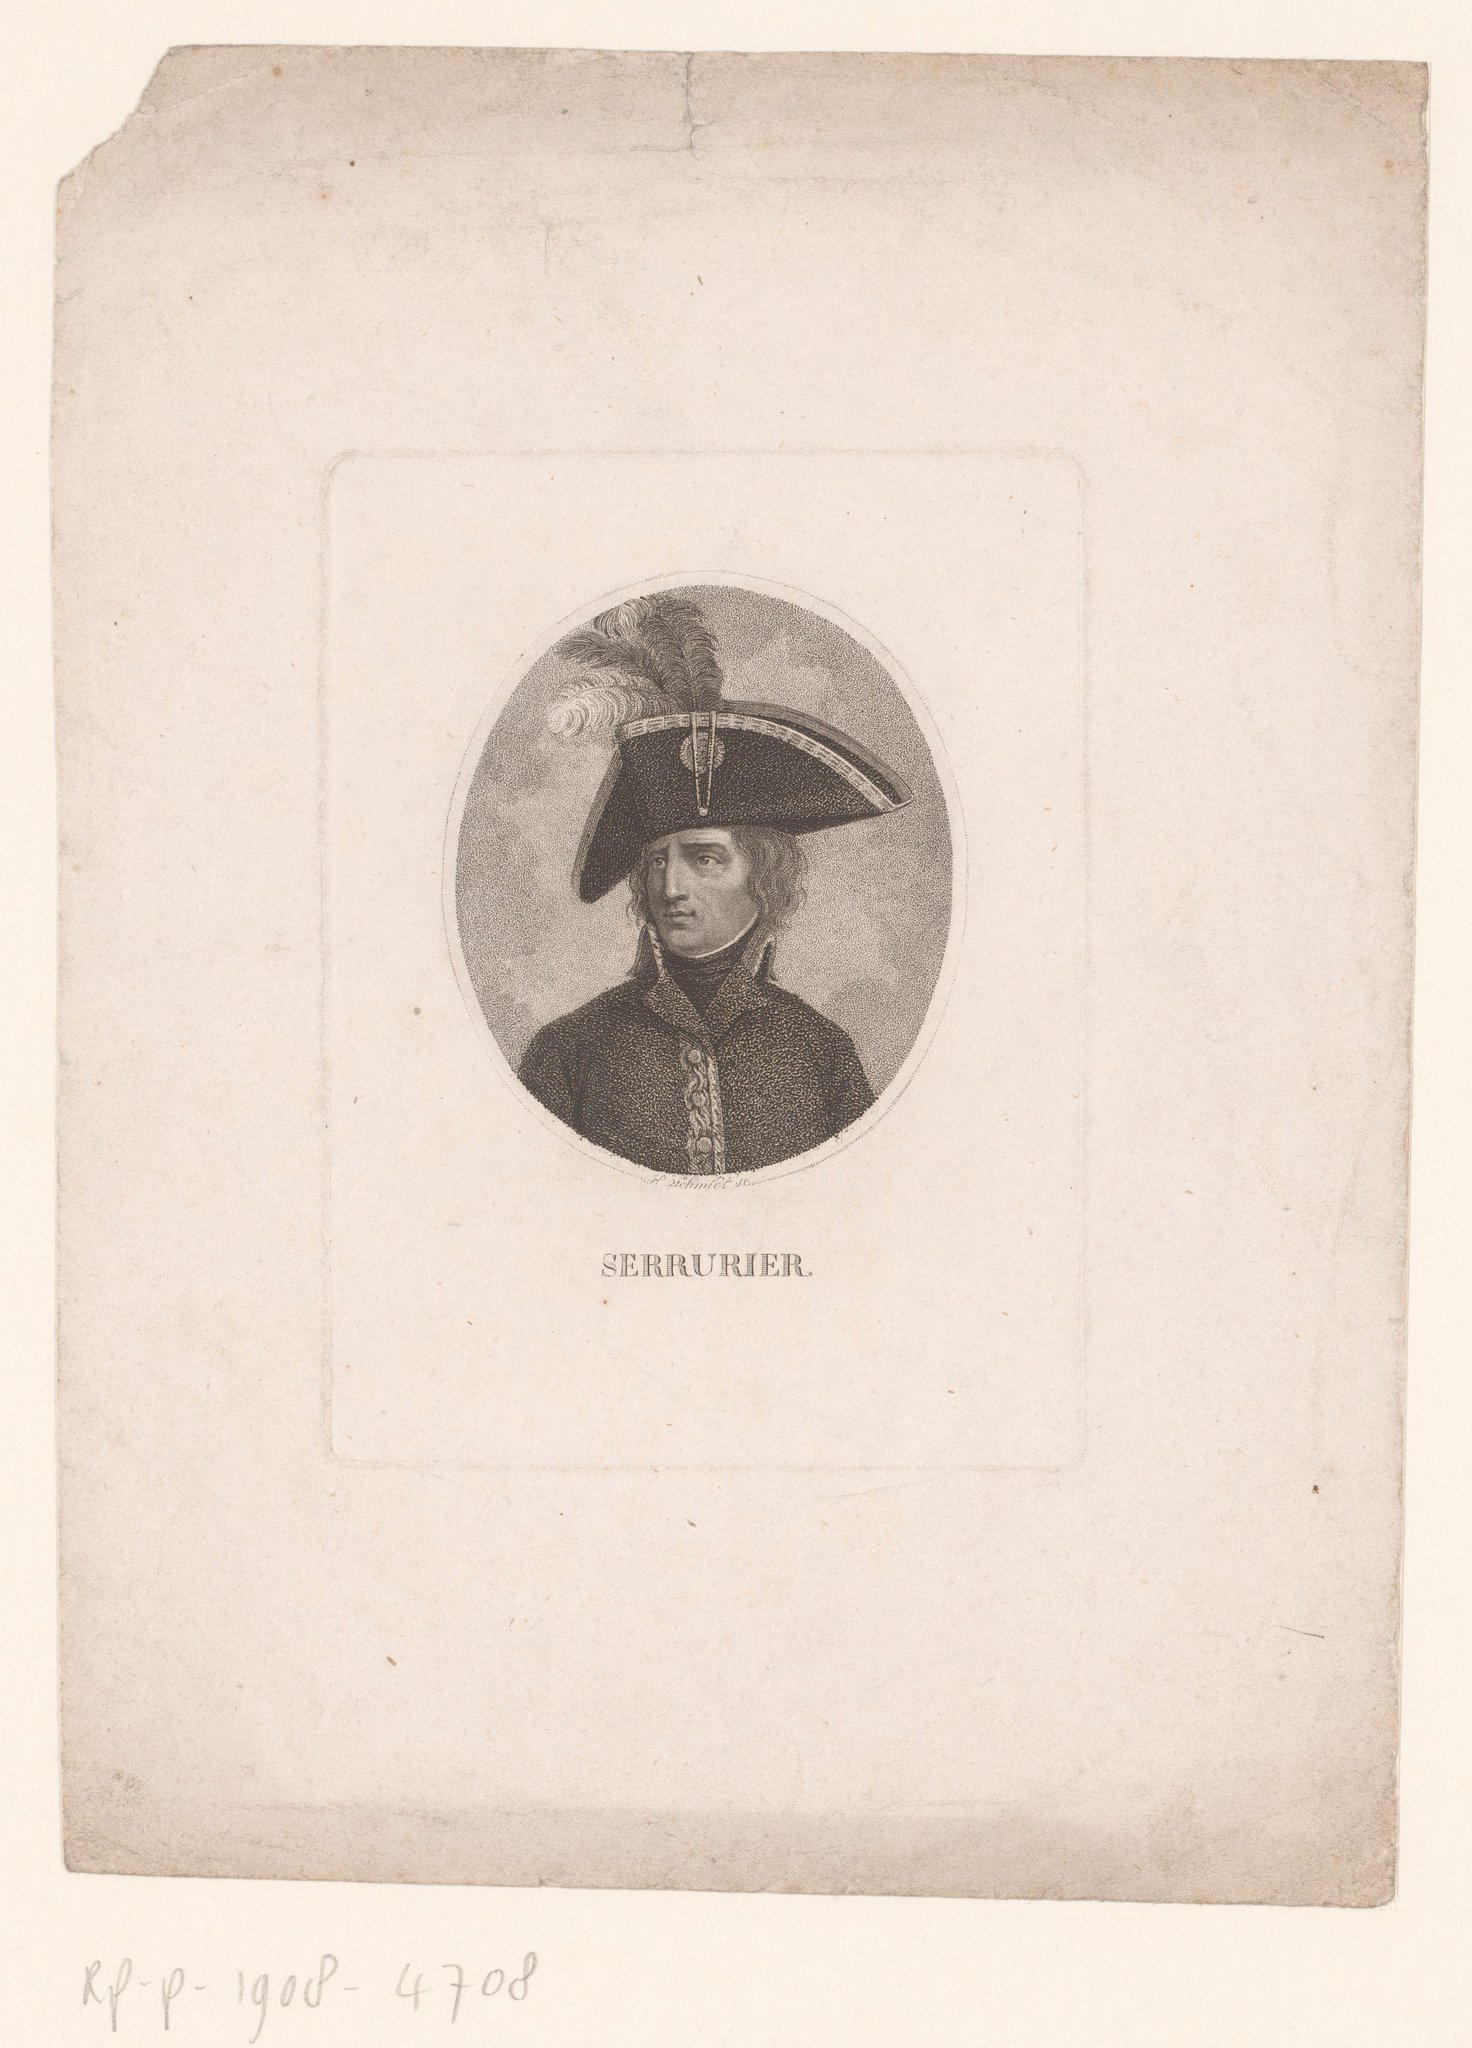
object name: print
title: Portret van Serrurier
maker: heinrich schmidt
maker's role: print maker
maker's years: 1740-1821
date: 1750-1821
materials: paper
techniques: engraving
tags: historical persons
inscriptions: collector's mark: Lugt 2228